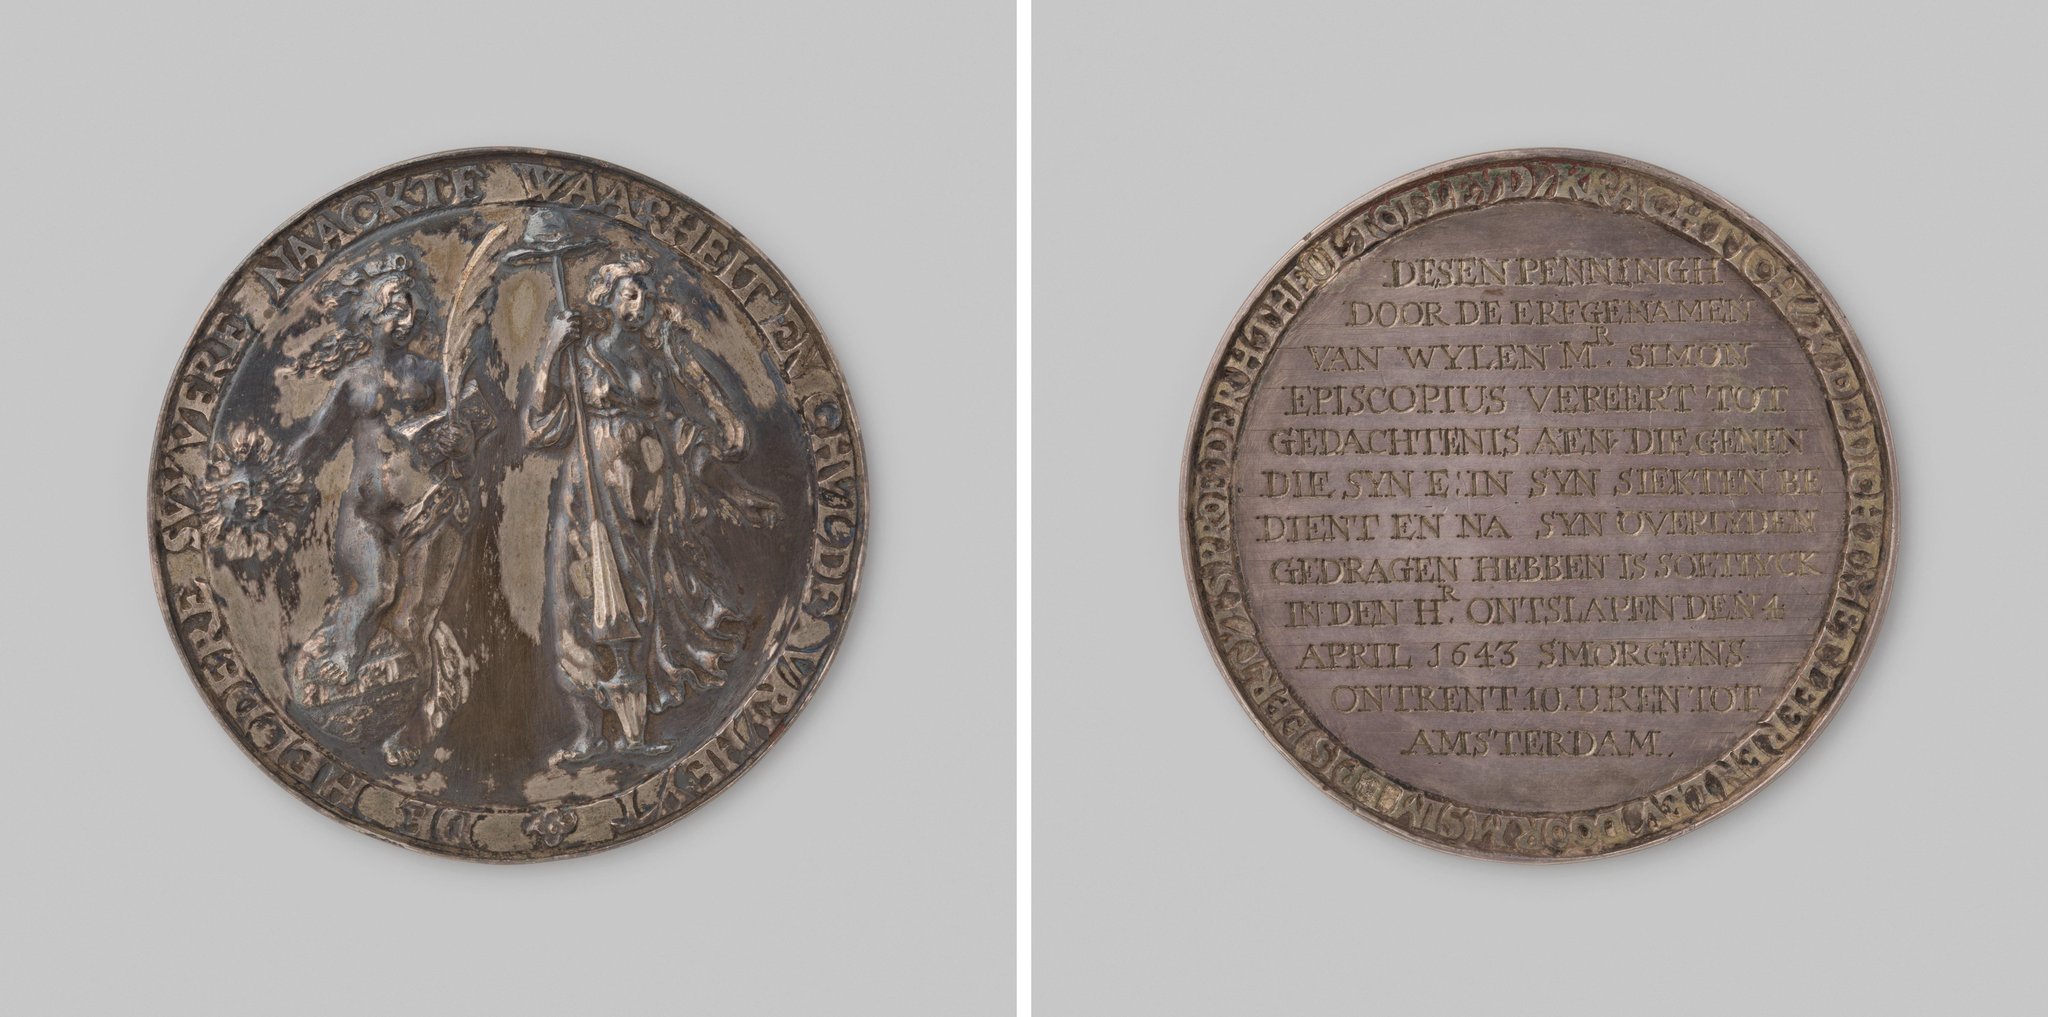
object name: family medal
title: Overlijden van Simon Episcopius 1643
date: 1643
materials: silver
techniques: casting, engraving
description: Gegoten zilveren penning, op de voorzijde naast elkaar de Waarheid en de Vrijheid, met omschrift, op de keerzijde een veld met een twaalfregelige inscriptie, met omschrift.